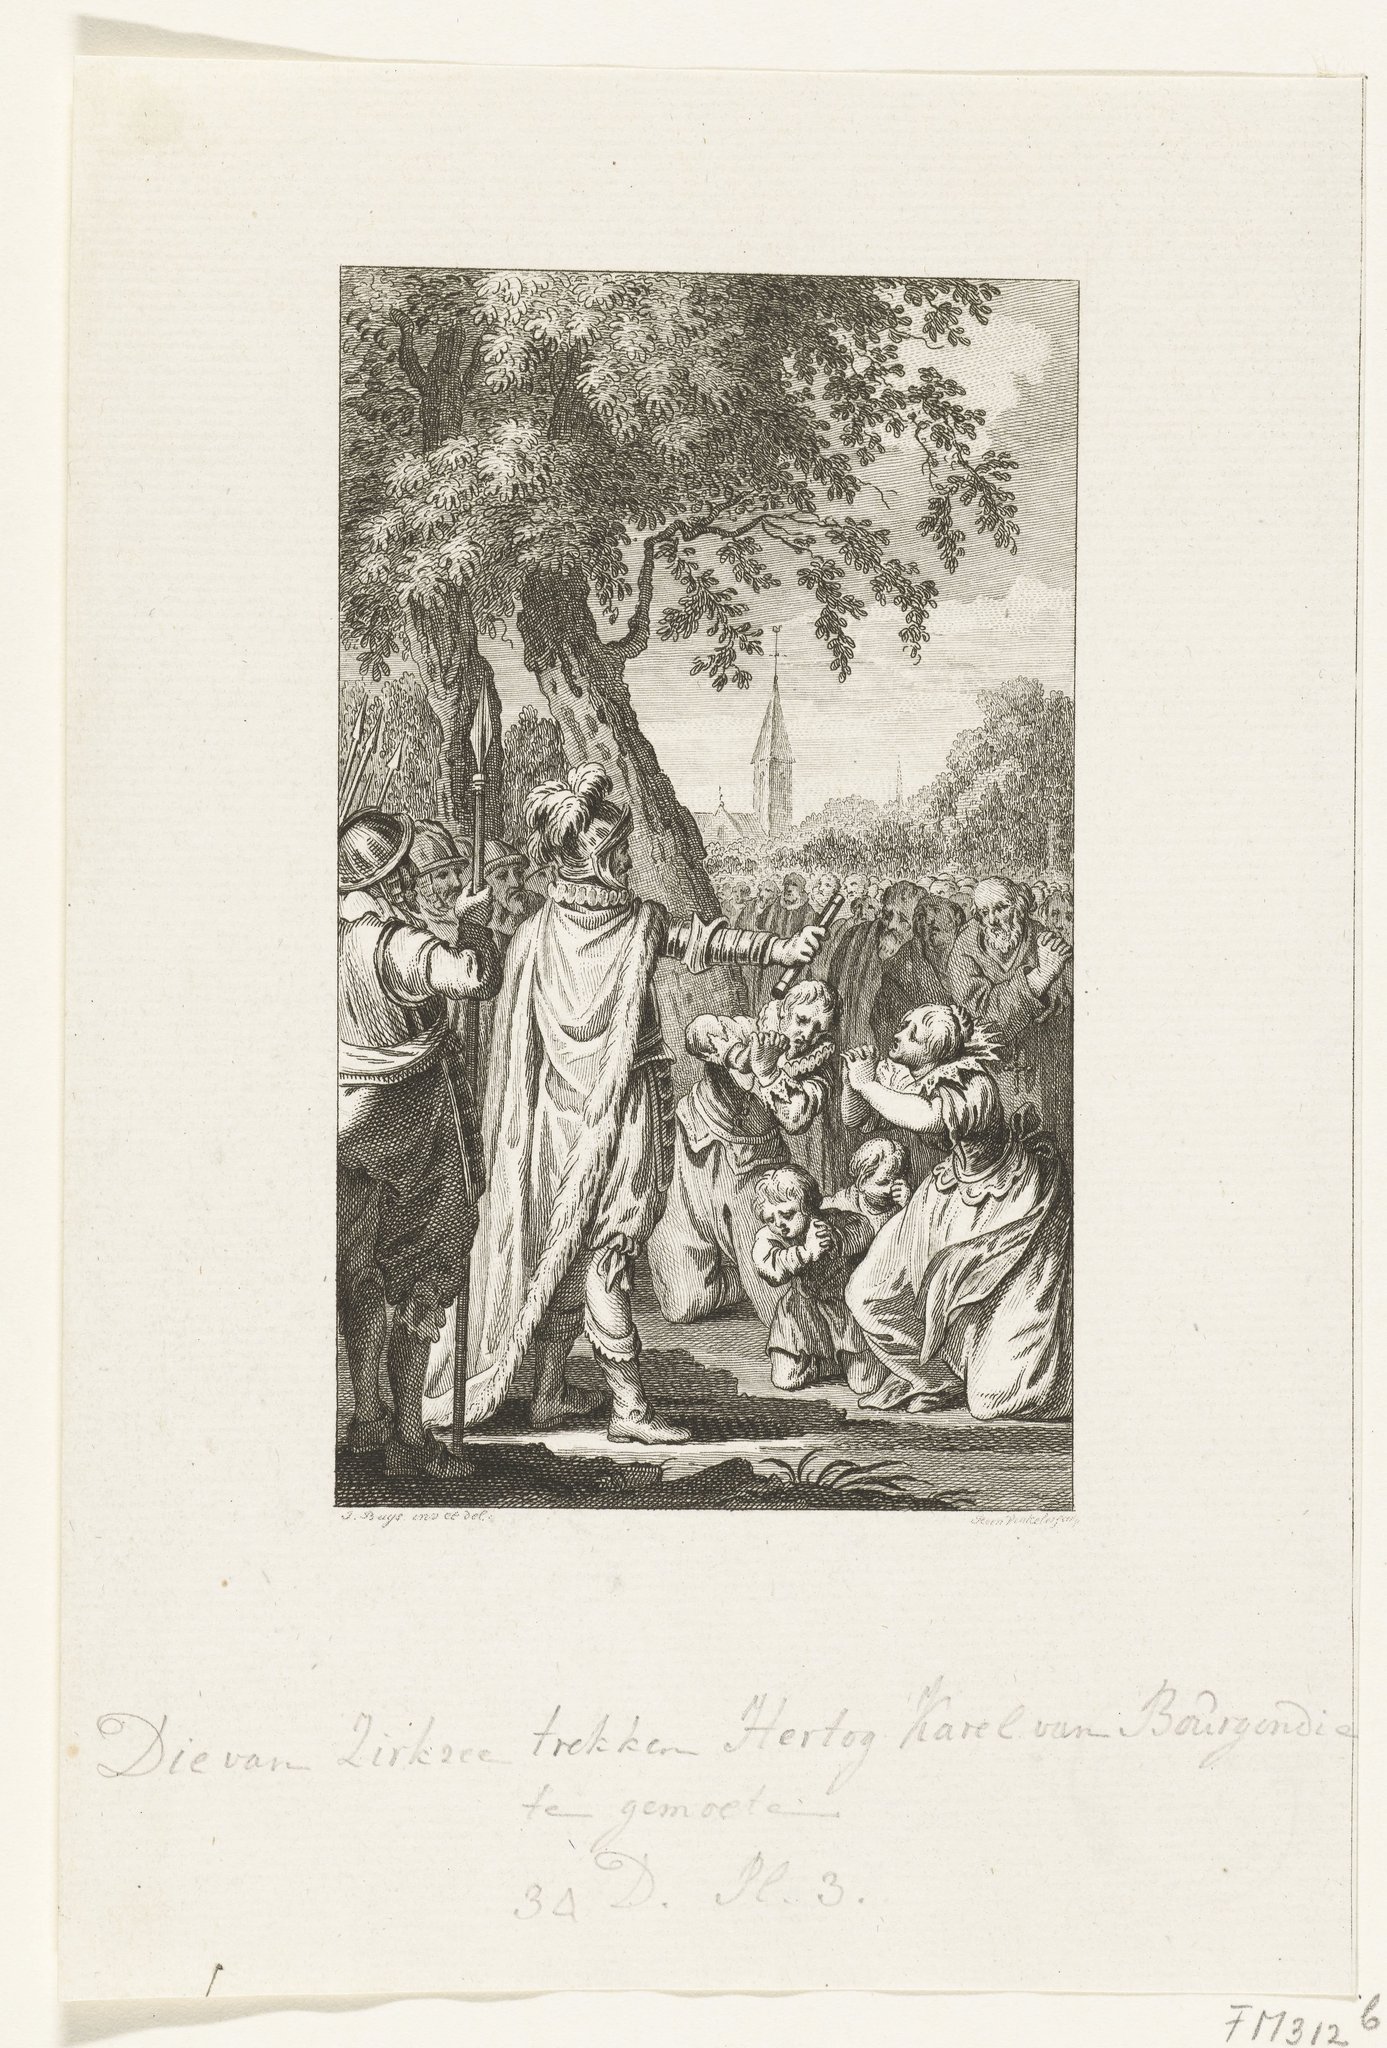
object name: history print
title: De inwoners van Zierikzee trekken Karel de Stoute tegemoet en smeken om genade, 1472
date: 1795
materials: paper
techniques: etching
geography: netherlands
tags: earl, charles the bold (duke of burgundy), burgundian netherlands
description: Illustratie voor: Jacobus Kok, Vaderlandsch Woordenboek, Johannes Allart, Amsterdam 1785-1799, 35 delen, dl. XXXIV, pl. III. Staat vóór de letter.